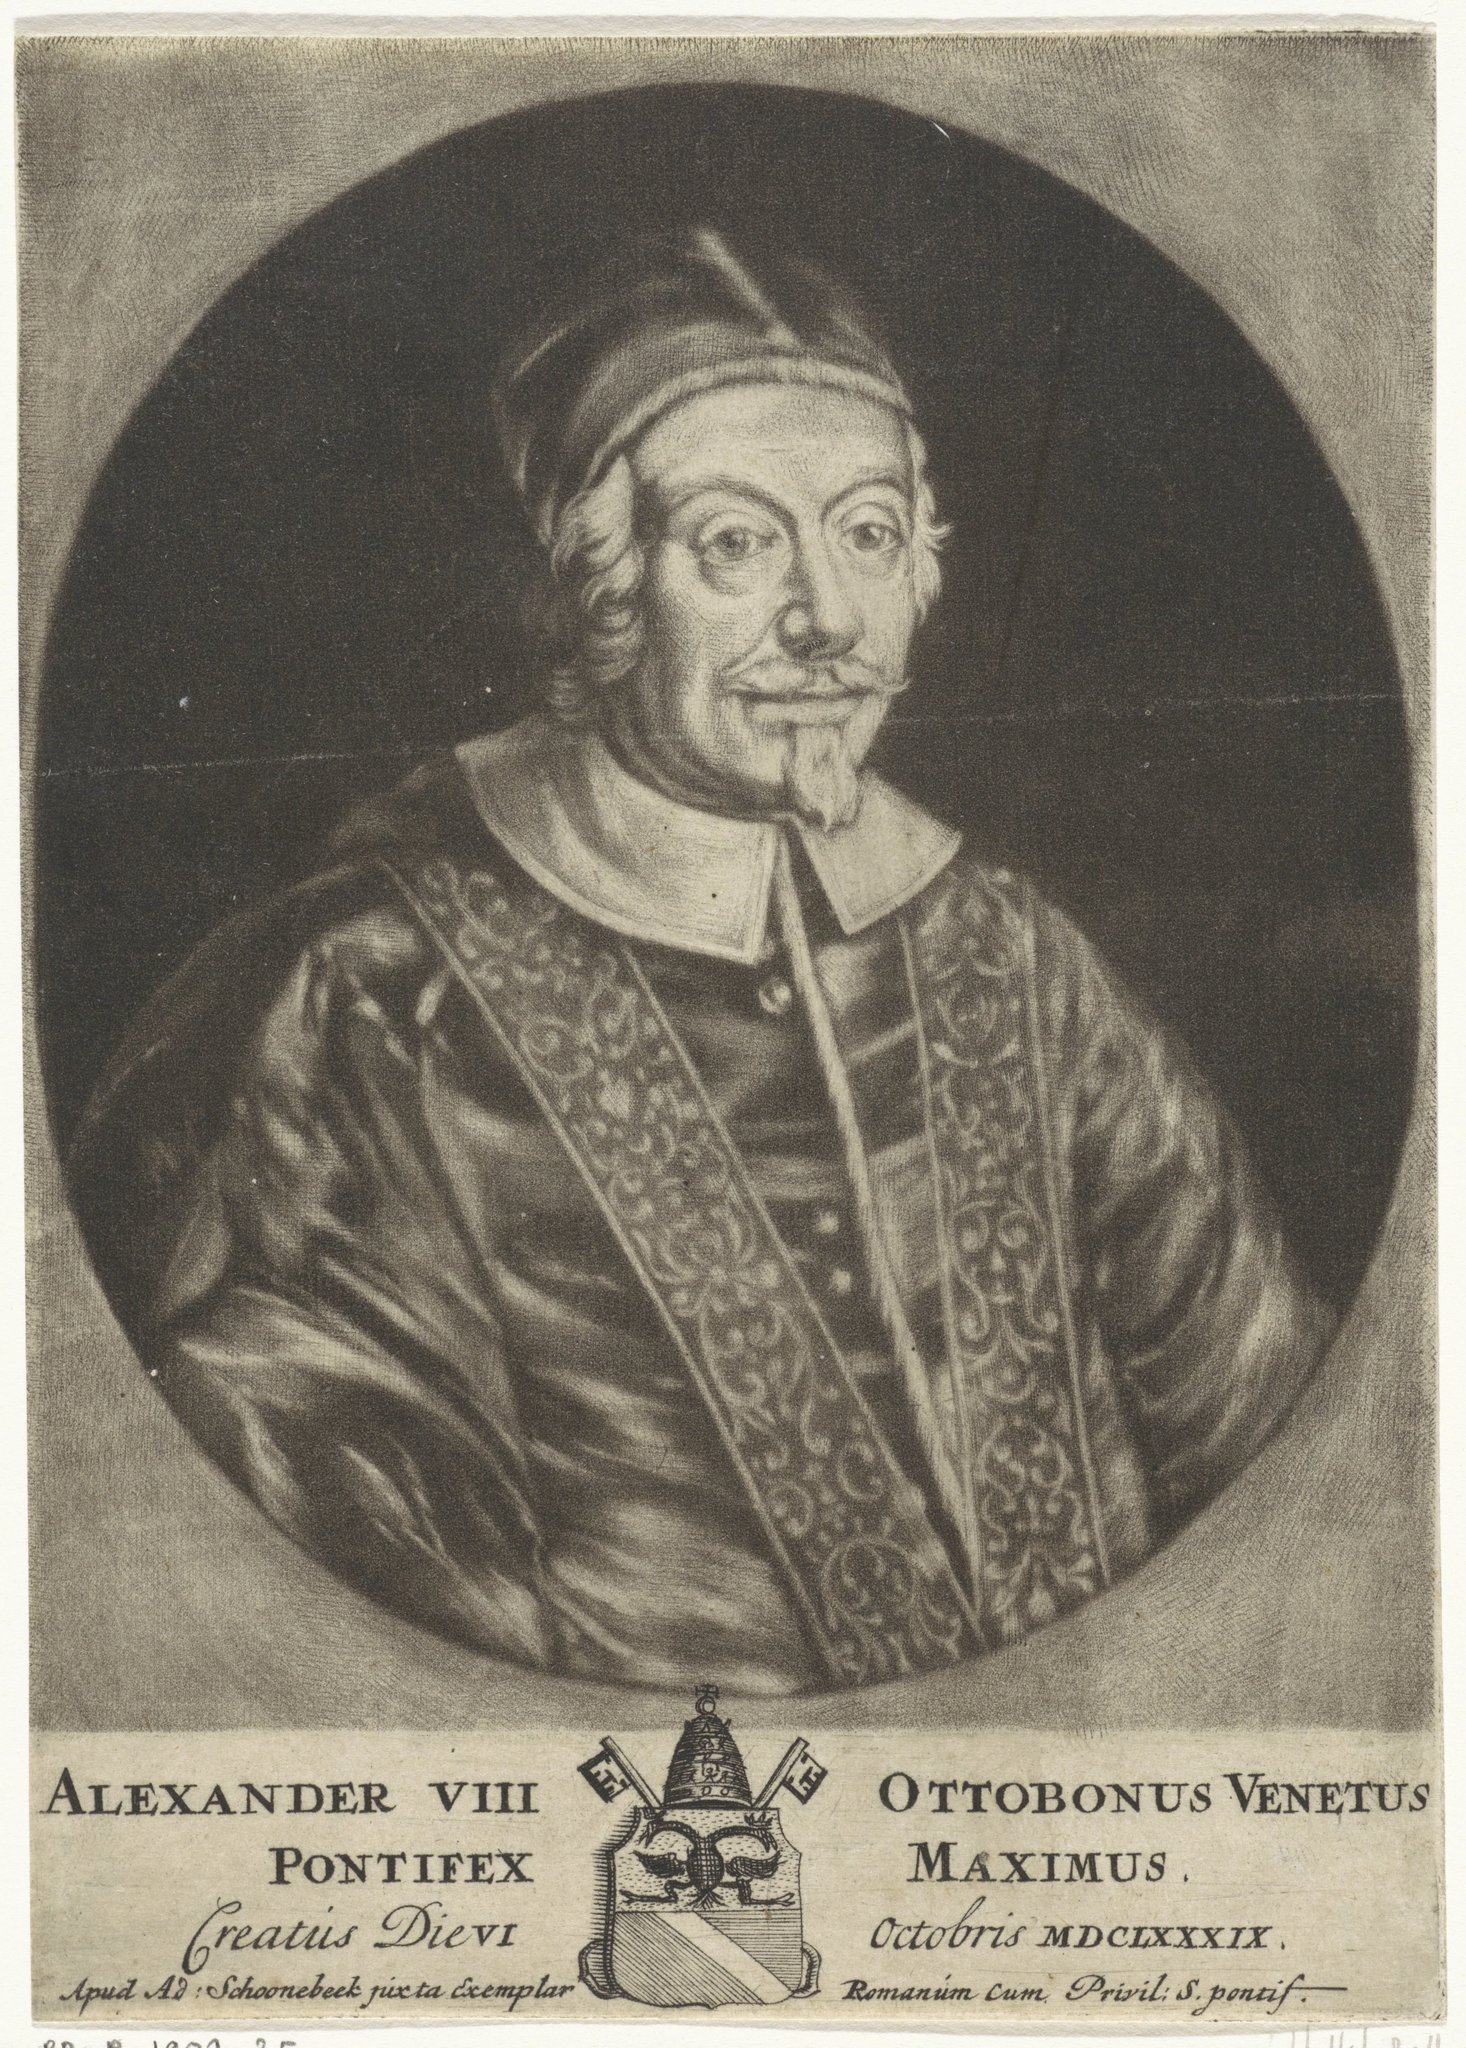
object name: print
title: Portret van paus Alexander VIII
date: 1689-1714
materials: paper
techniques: etching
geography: amsterdam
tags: venice, rome, clergyman, alexander viii, armorial bearing, heraldry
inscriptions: collector's mark: Lugt 2228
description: Paus Alexander VIII, in de marge zijn titels en familiewapen.